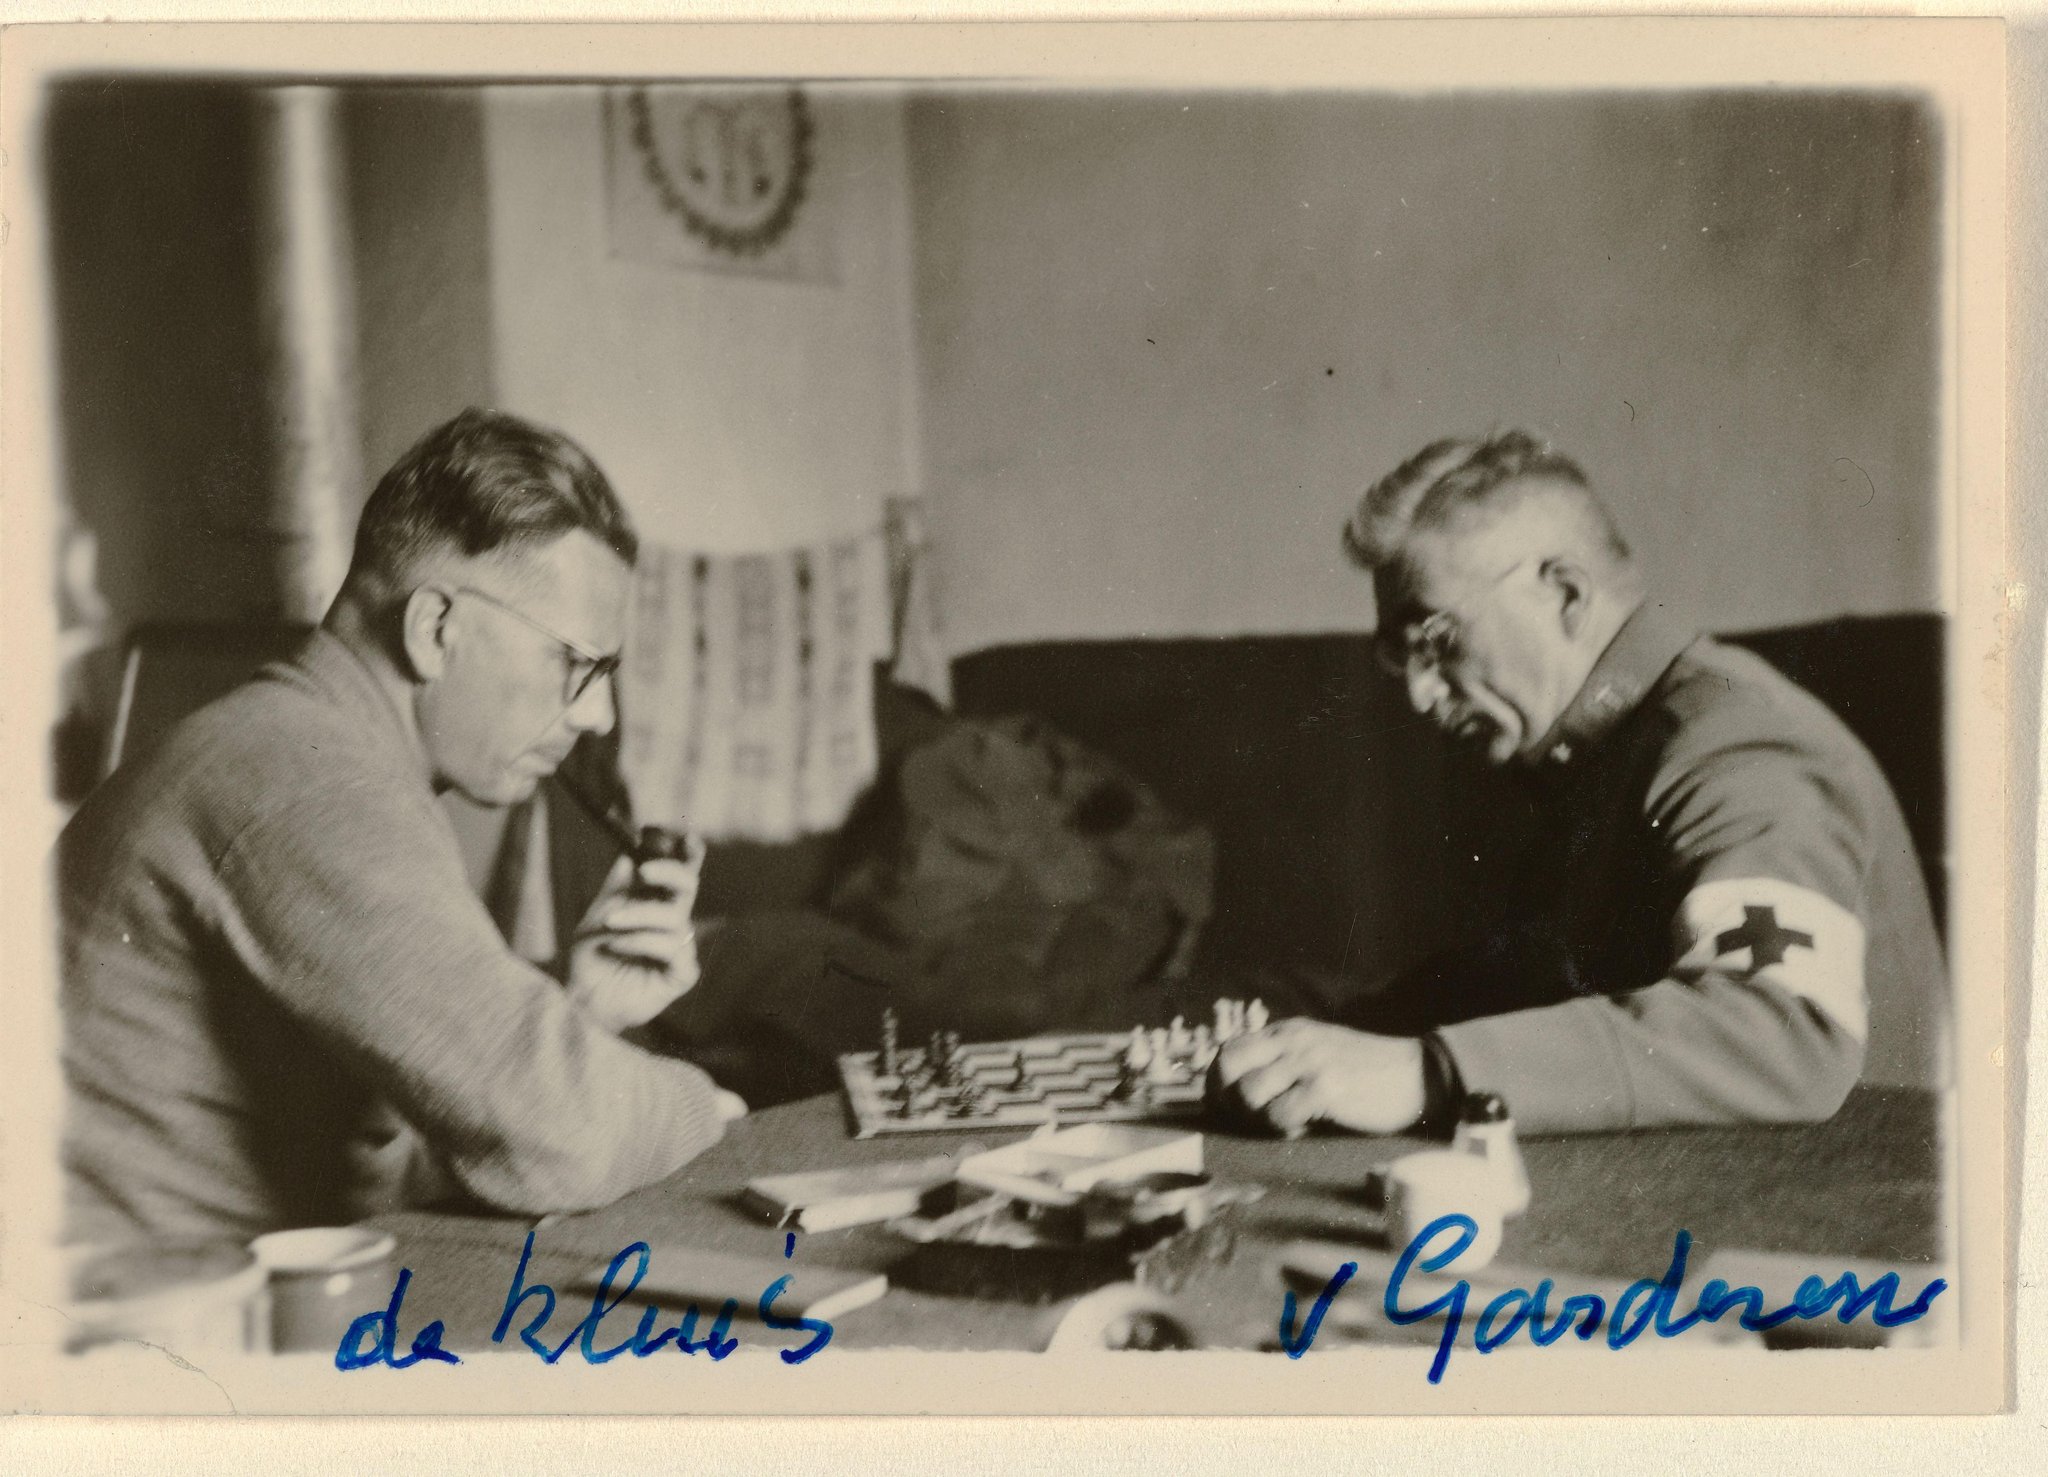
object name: photograph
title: Legerpredikanten De Kluis en Van Garderen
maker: dick w.b. van maarseveen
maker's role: fotograaf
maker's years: 1905-1990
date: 1943-1945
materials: photographic support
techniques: gelatin silver print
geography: muhlberg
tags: dick w.b. van maarseveen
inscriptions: inscription: ‘de kluis / v Garderen’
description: De twee legerpredikanten voor de Nederlandse krijgsgevangenen: dominee De Kluis en Van Garderen. Zij spelen een potje schaak, zittend aan een tafel. Onderdeel van een groep foto's gemaakt door Dick van Maarseveen in het Duitse krijgsgevangenenkamp Stalag IV B in Mühlberg in de periode 1943-1945.